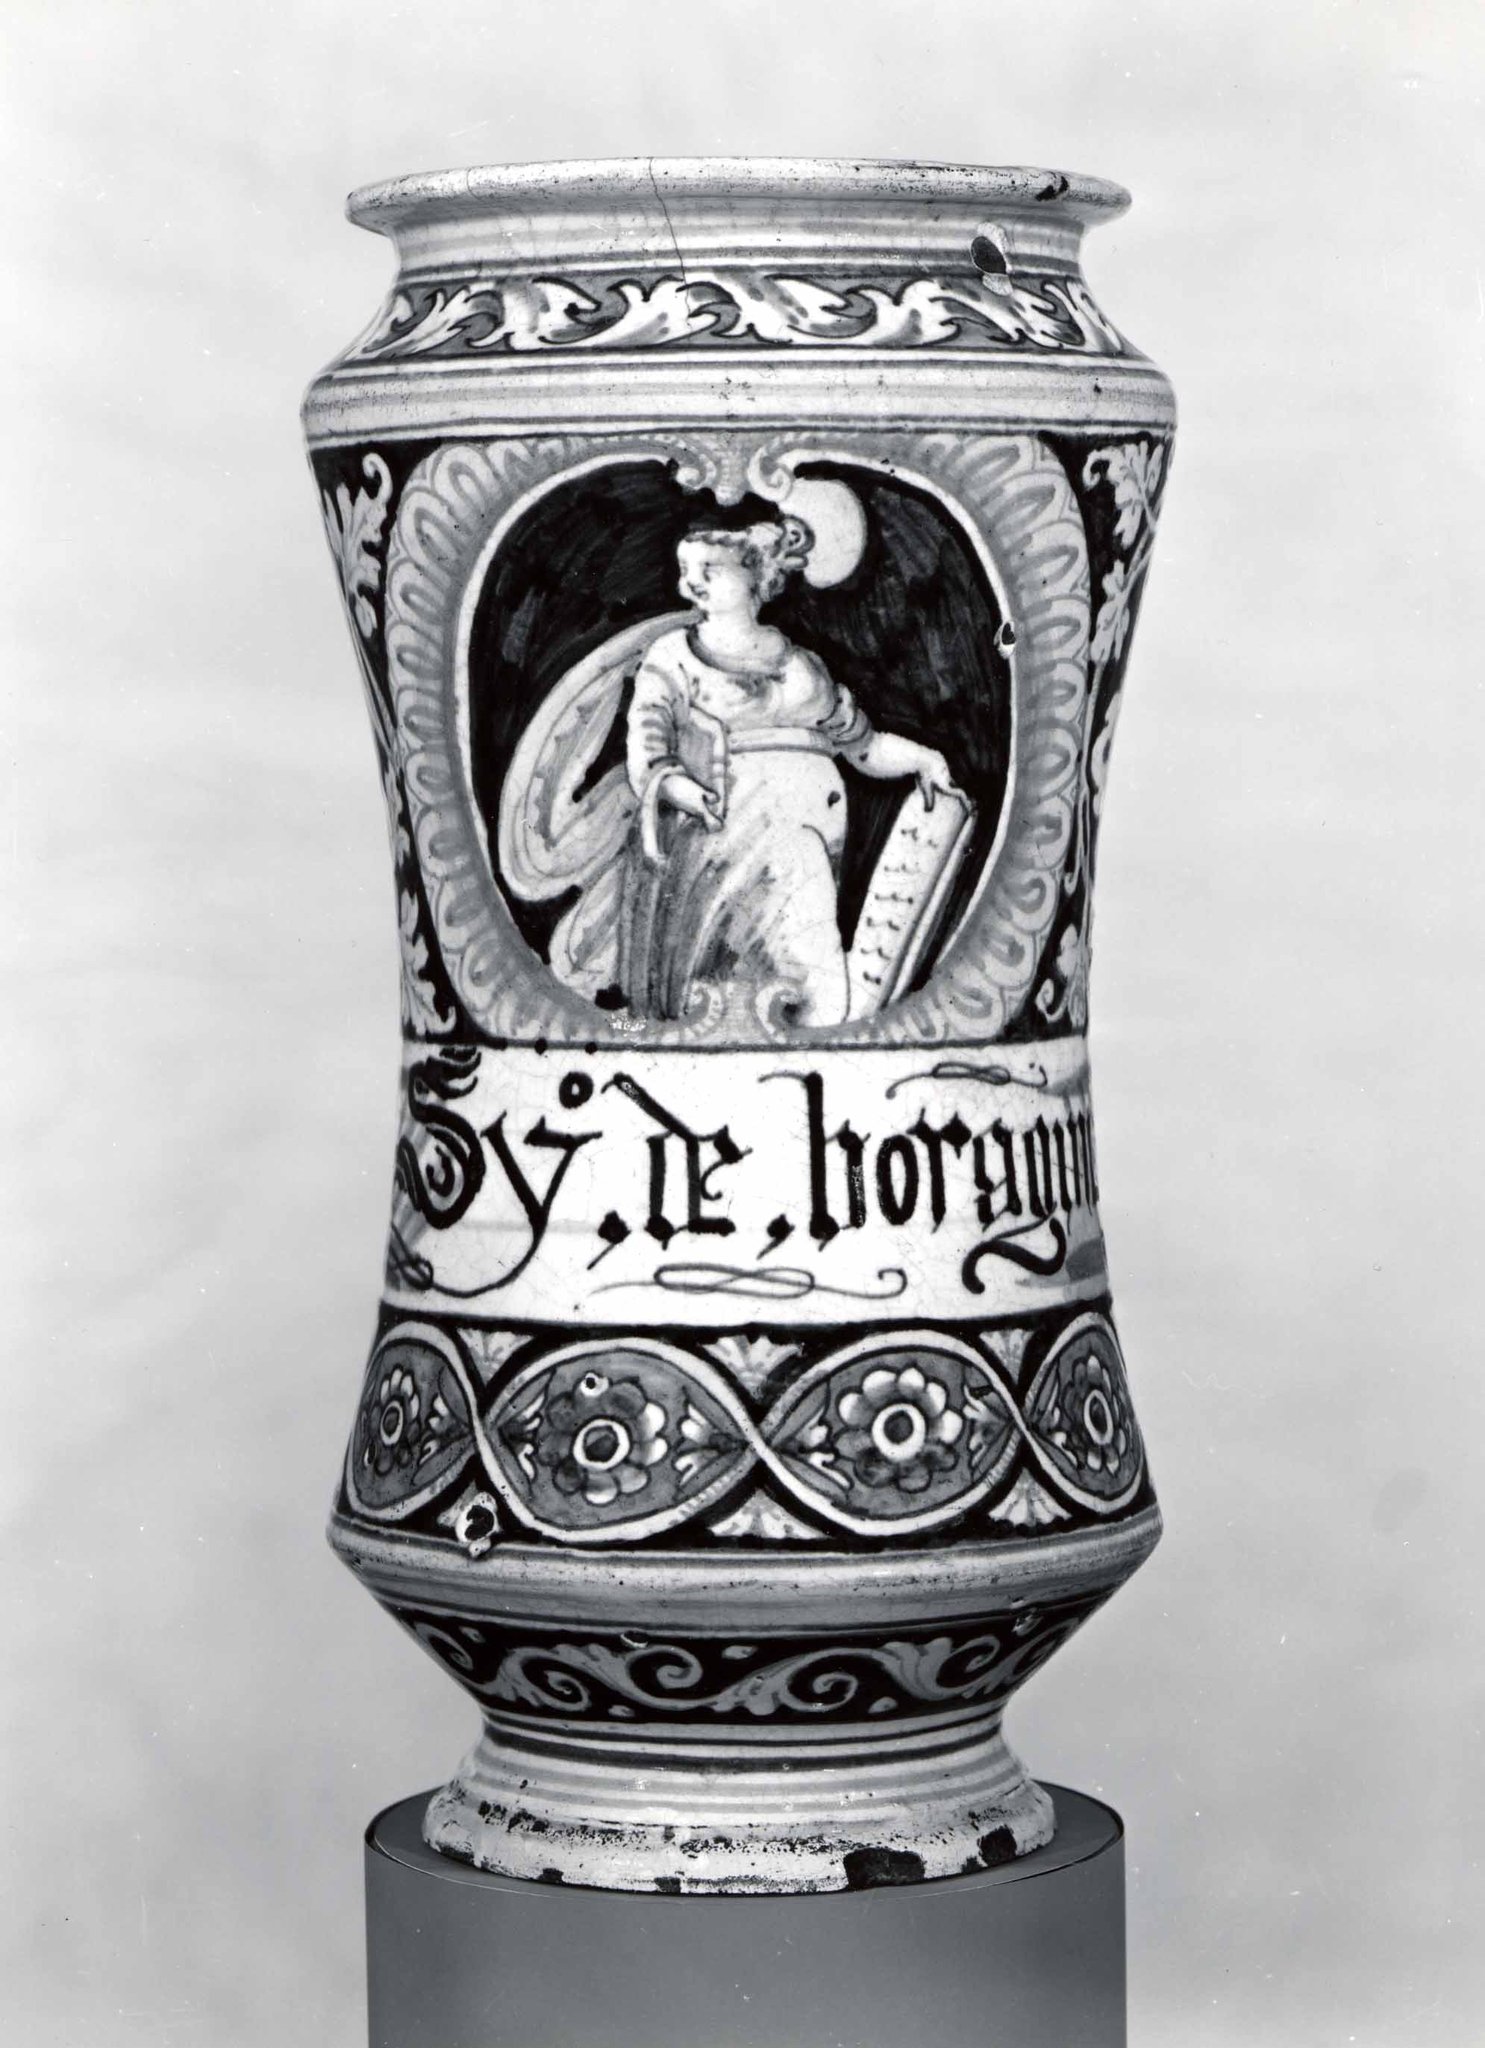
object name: albarello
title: Apothecary jar (albarello)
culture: italian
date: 1550-1600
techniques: maiolica, glazing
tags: women